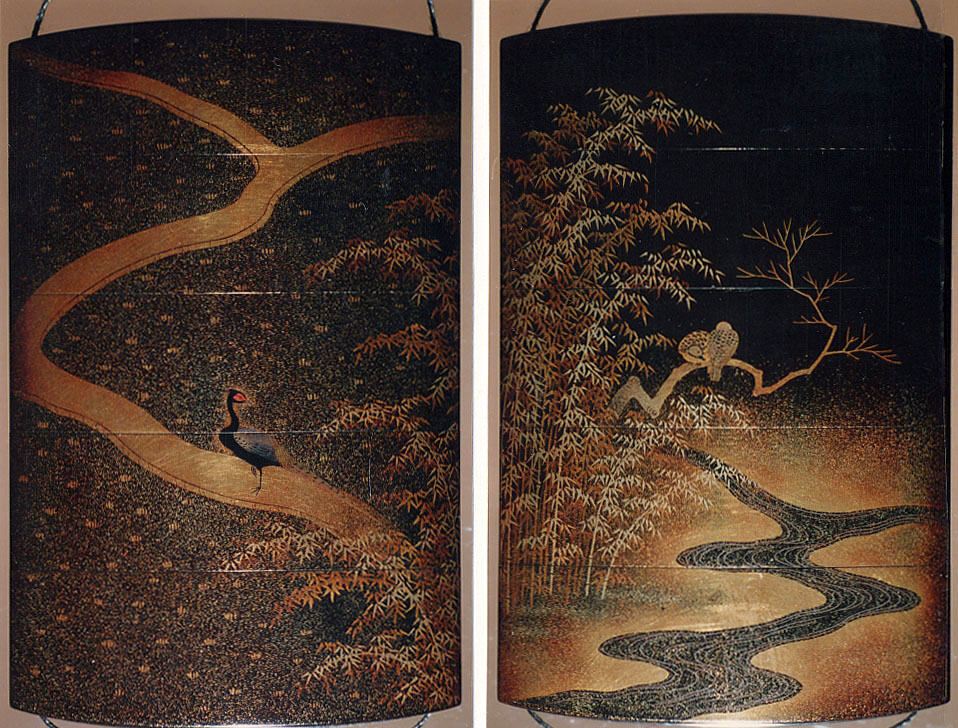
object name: inrō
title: Case (Inrō) with Design of Pheasant on Path (obverse); Two Birds on Tree over Winding River (reverse)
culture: japanese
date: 1801-1900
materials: gold, lacquer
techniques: fundame, roiro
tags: birds,pheasants,rivers